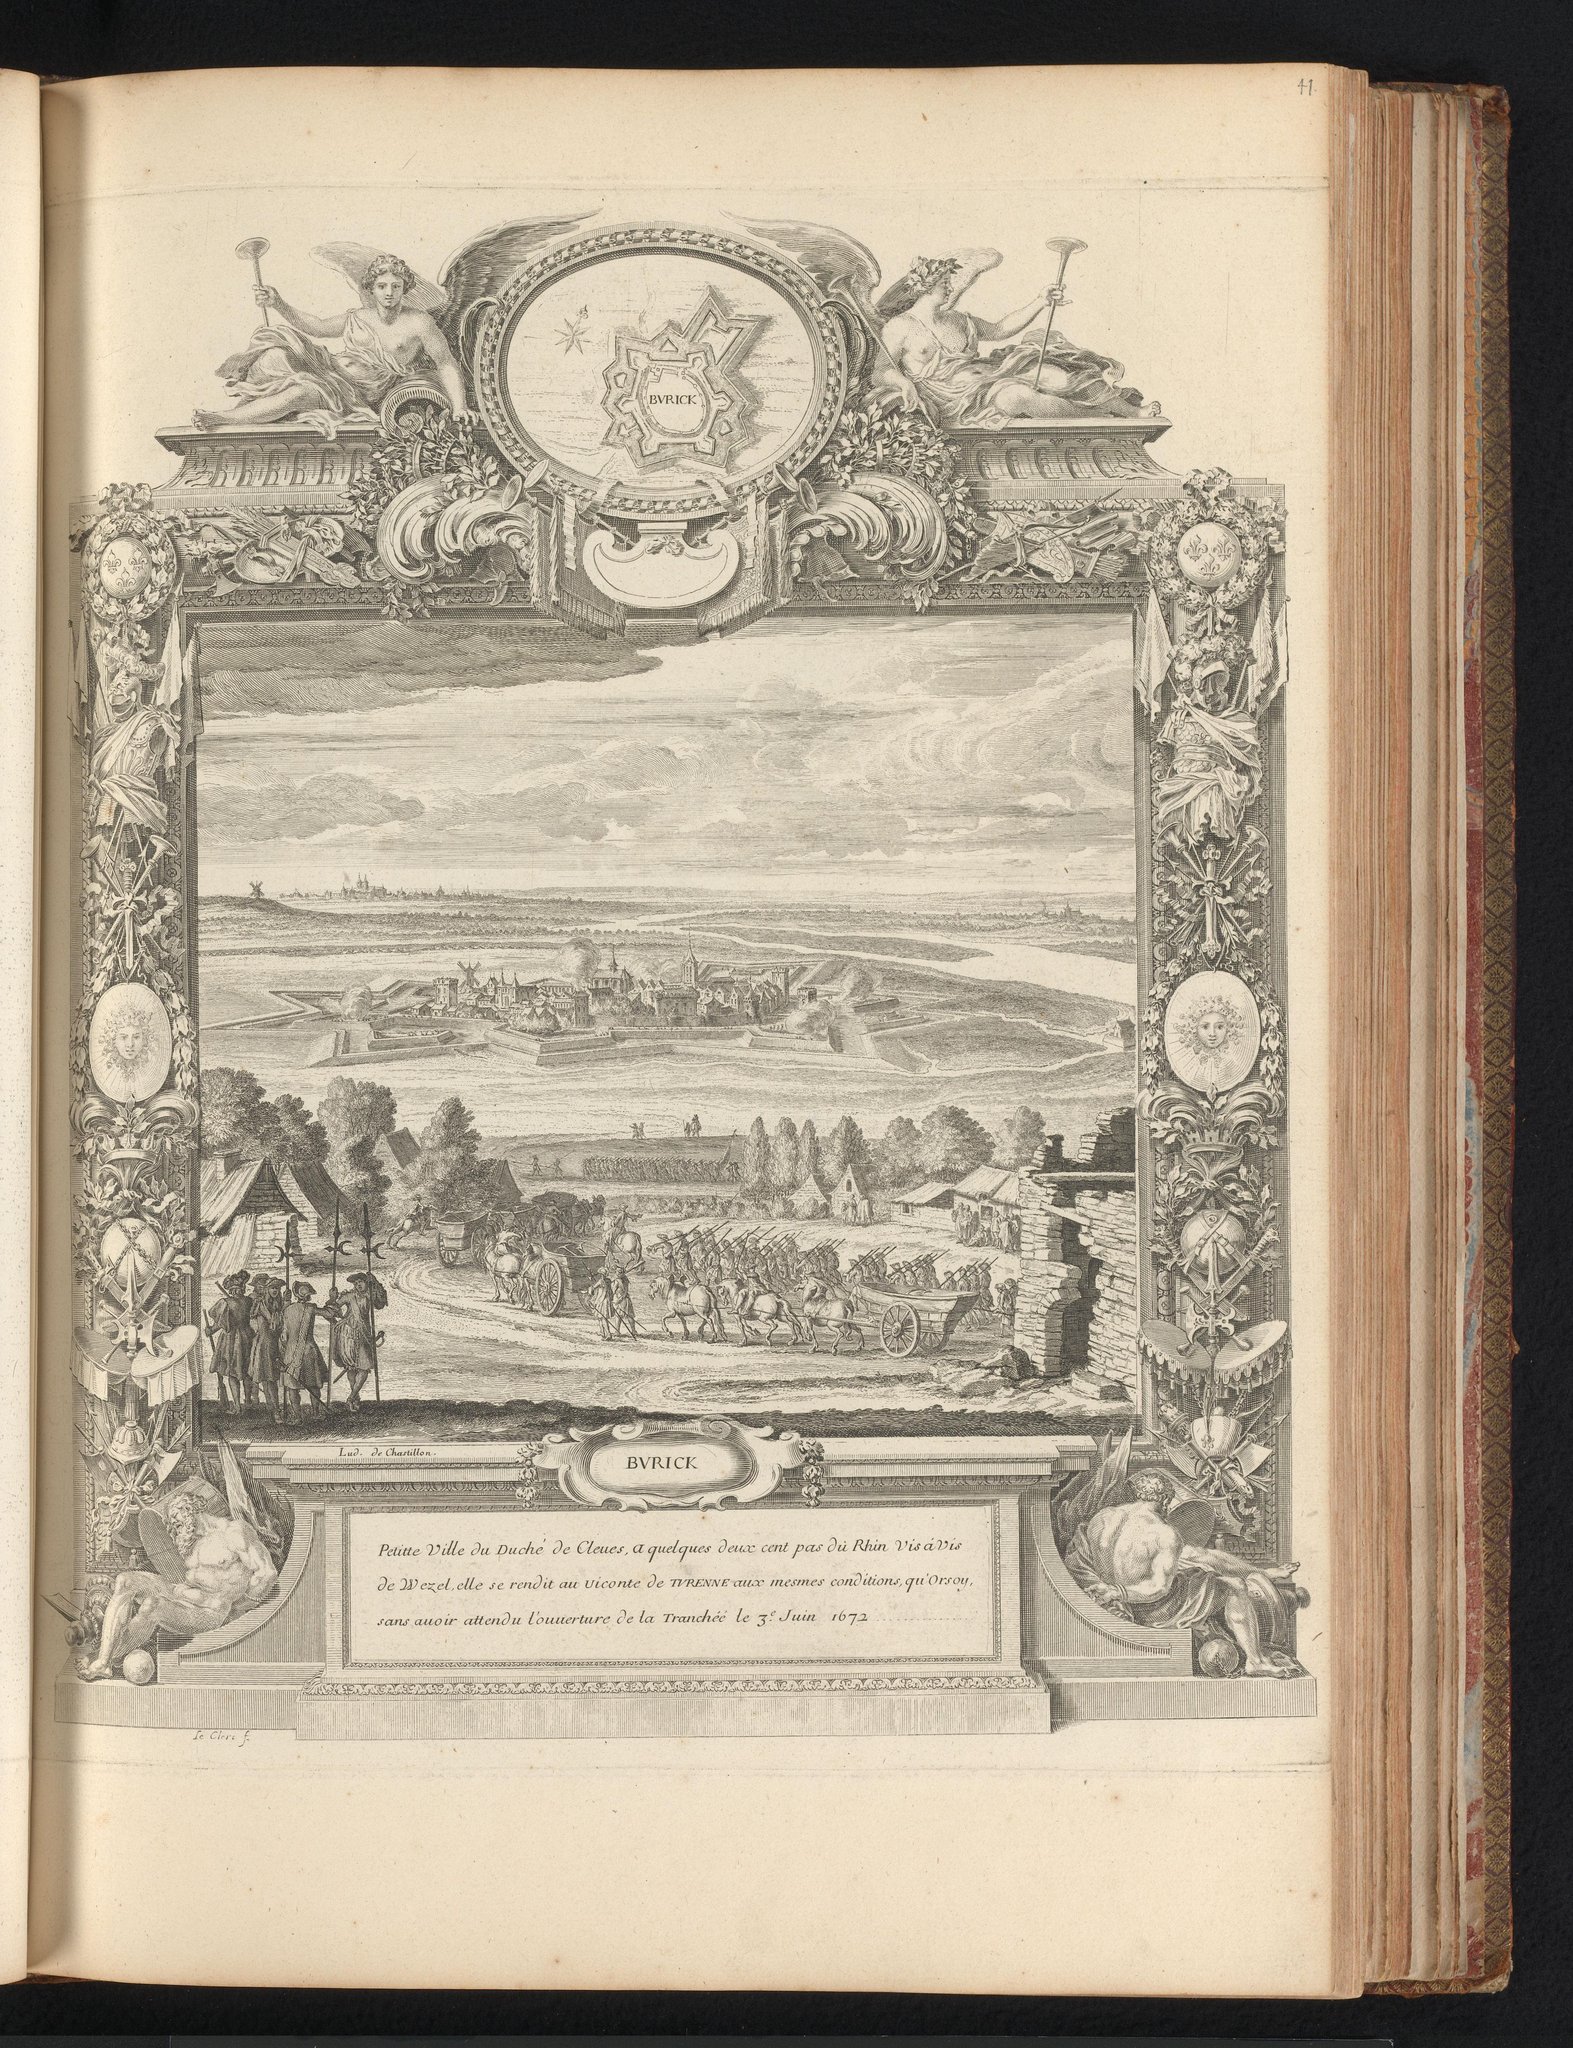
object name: print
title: Grote overwinningen van koning Lodewijk XIV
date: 1686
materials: paper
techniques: engraving, etching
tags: battle, capture of city (after the siege)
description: Maakt deel uit van een serie bestaande uit 28 prenten met oorlogstaferelen in ornamentele cartouches. De prenten zijn gedrukt van twee afzonderlijke platen bestaande uit de voorstelling en de cartouche.